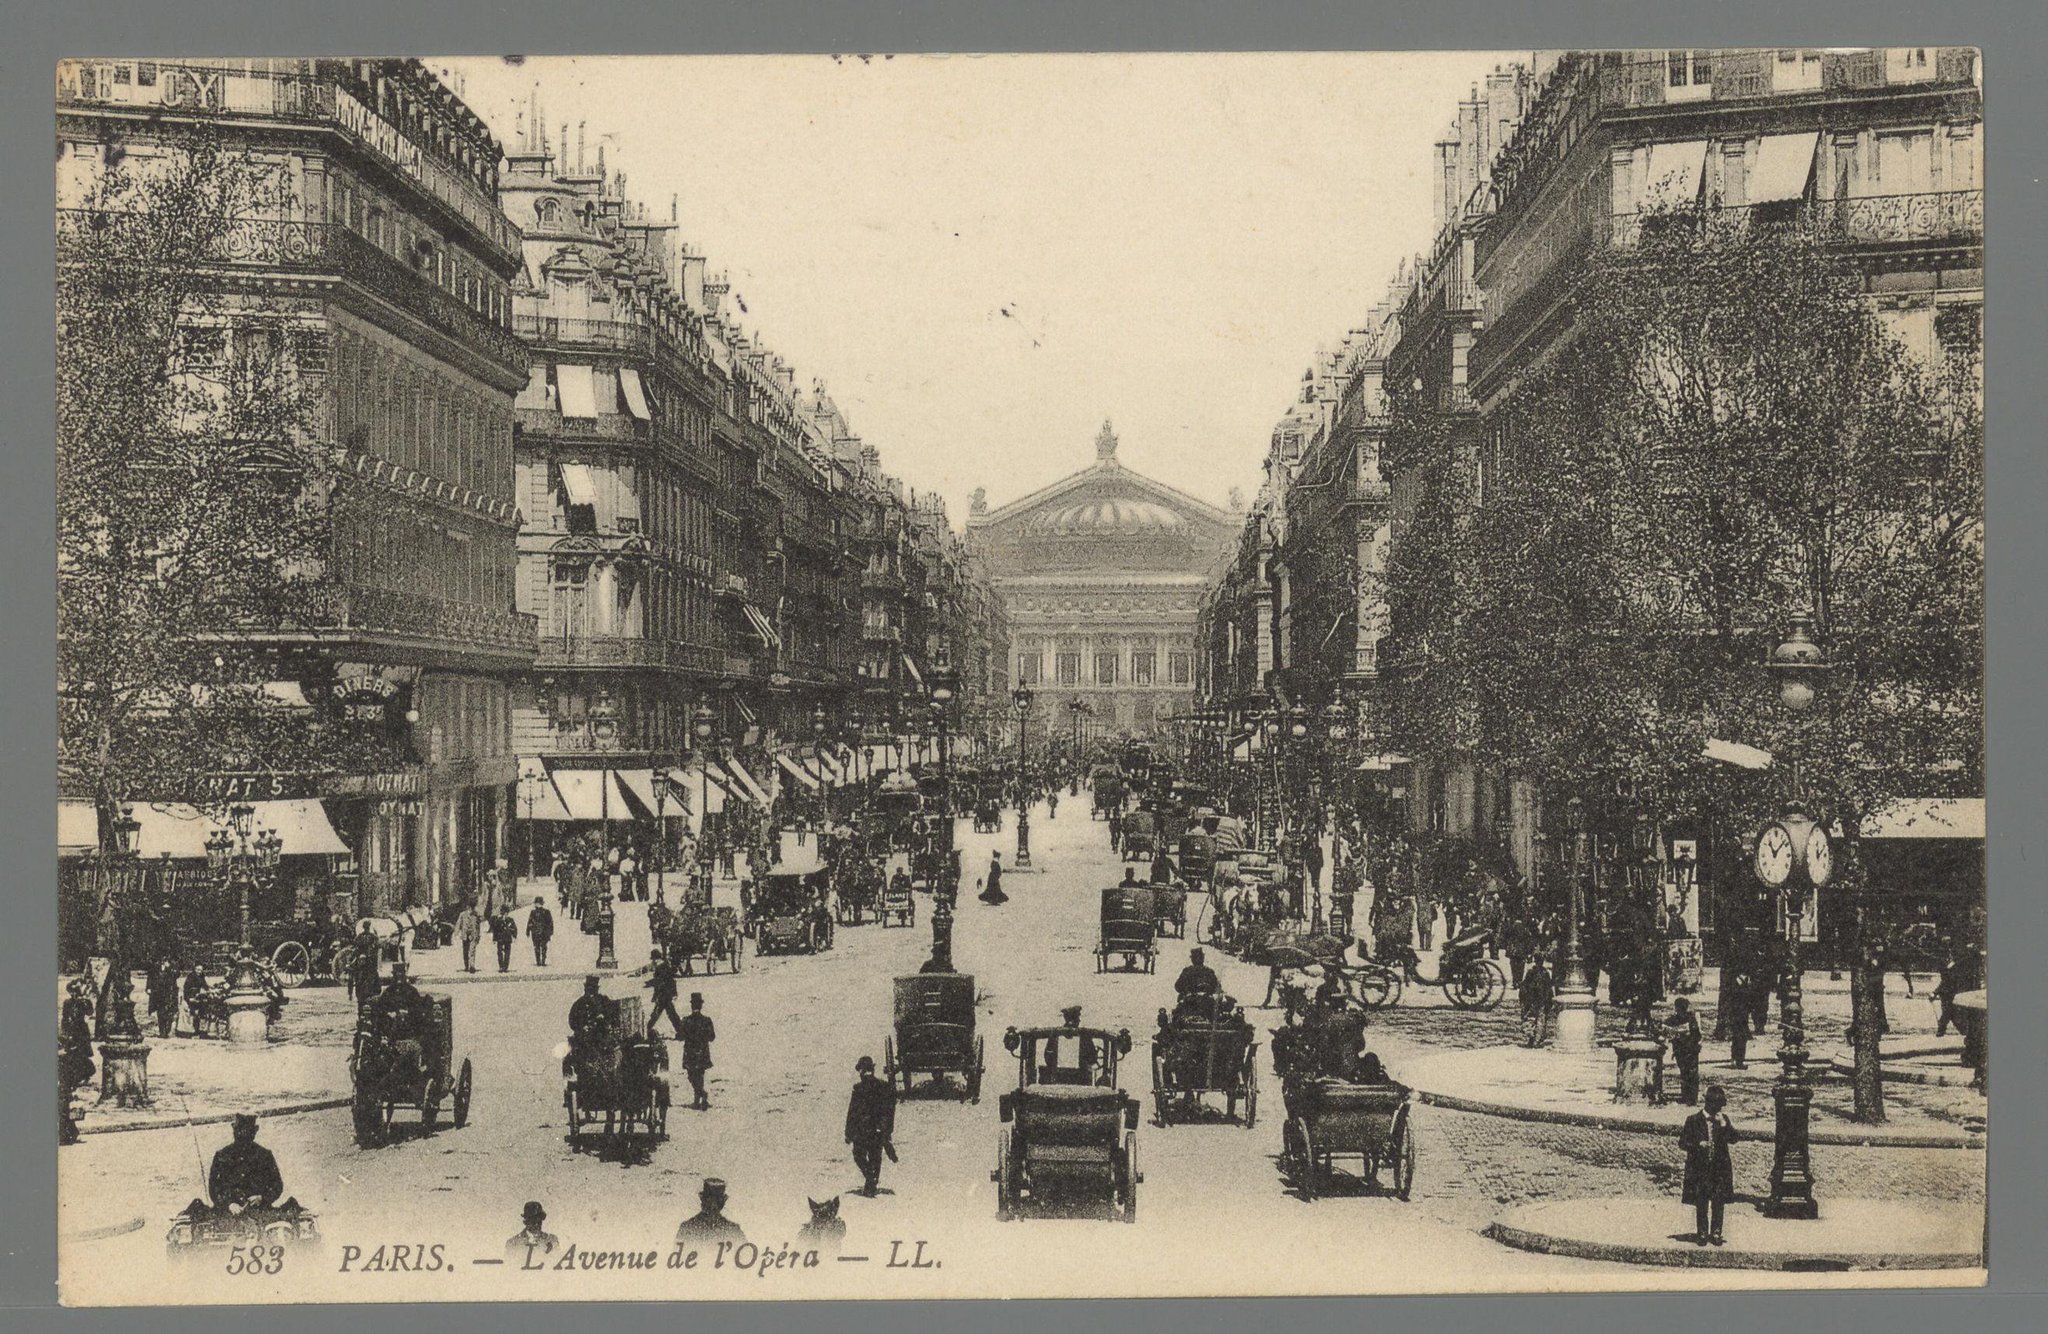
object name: photomechanical print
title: Paris. L'Avenue de l'Opéra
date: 1904-1906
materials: cardboard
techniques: photograph, writing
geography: paris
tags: avenue, boulevard, promenade, esplanade (+ city(-scape) with figures, staffage), opera house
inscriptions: postage stamp